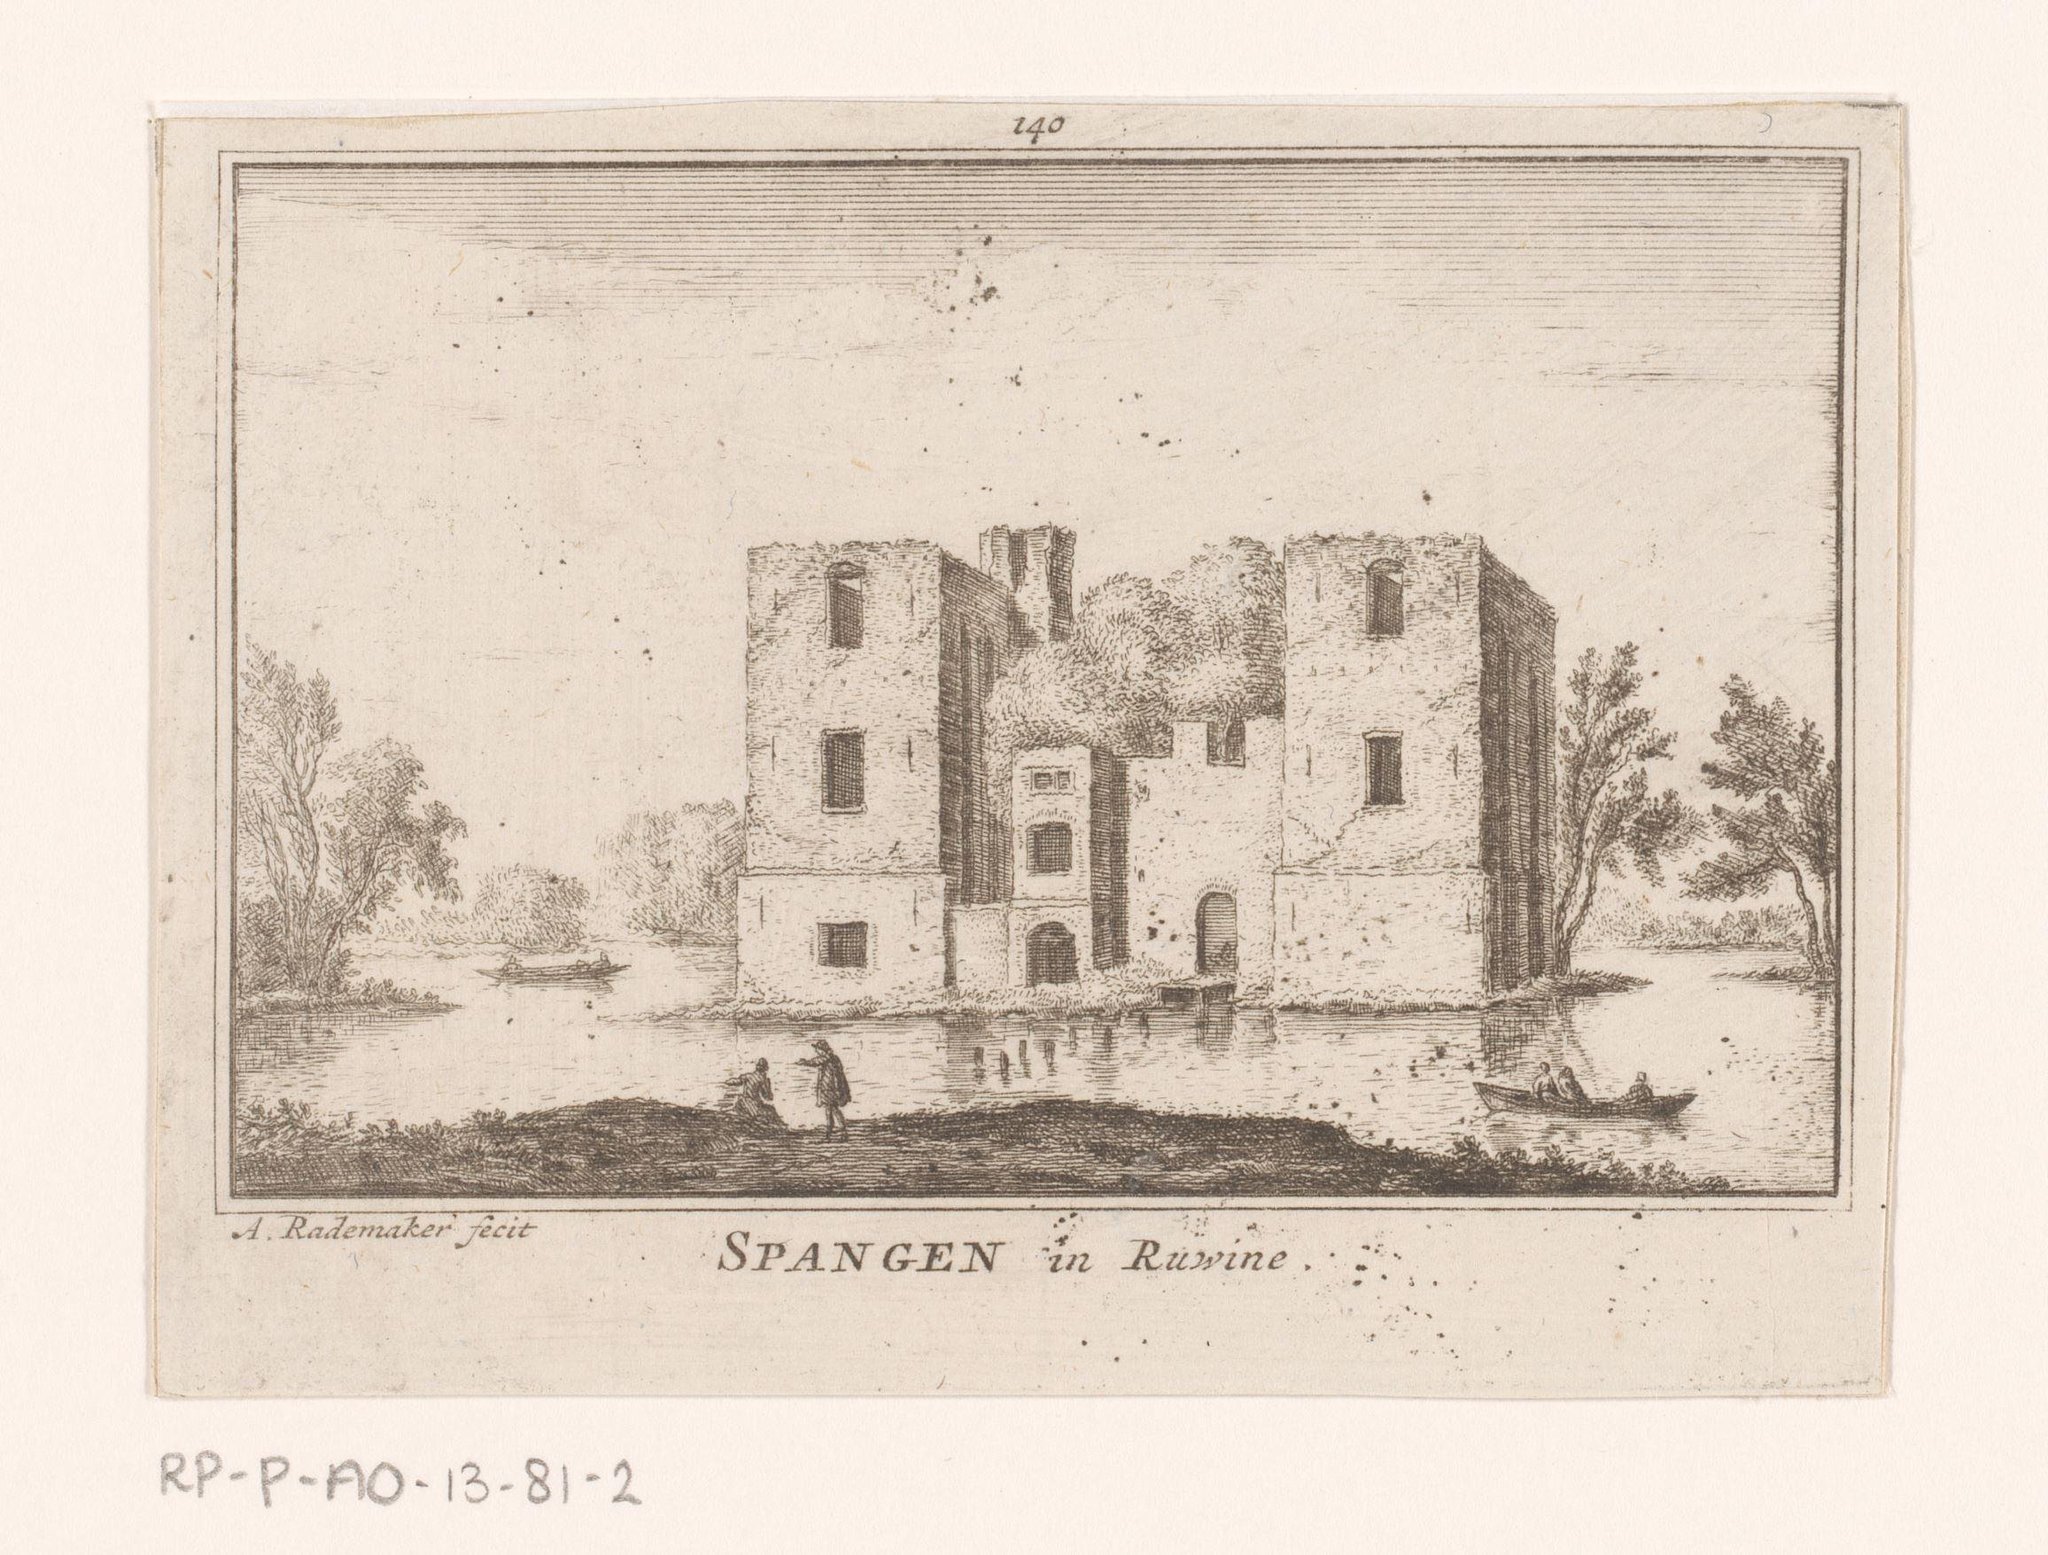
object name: print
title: Gezicht op de ruïne van Kasteel Spangen, 1573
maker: abraham rademaker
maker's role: draughtsman, print maker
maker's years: 1676-1735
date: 1725-1803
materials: paper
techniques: engraving, etching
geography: amsterdam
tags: rowing-boat, canoe, etc., ruin of a dwelling, house, castle, etc.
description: Prent ook gebruikt in: Rademaker, Abraham. Kabinet van Nederlandsche outheden en gezichten: vervat in 300 konstplaaten (…). 2 delen. Amsterdam: Willem Barents, 1725, dl. 1, ill. 140. Na 1725 is deze prent nog in verschillende heruitgaven verschenen, uitgegeven in 1727-1733, 1770-1771 en 1792-1803. Uit welke uitgave het huidige exemplaar precies komt is niet na te gaan.